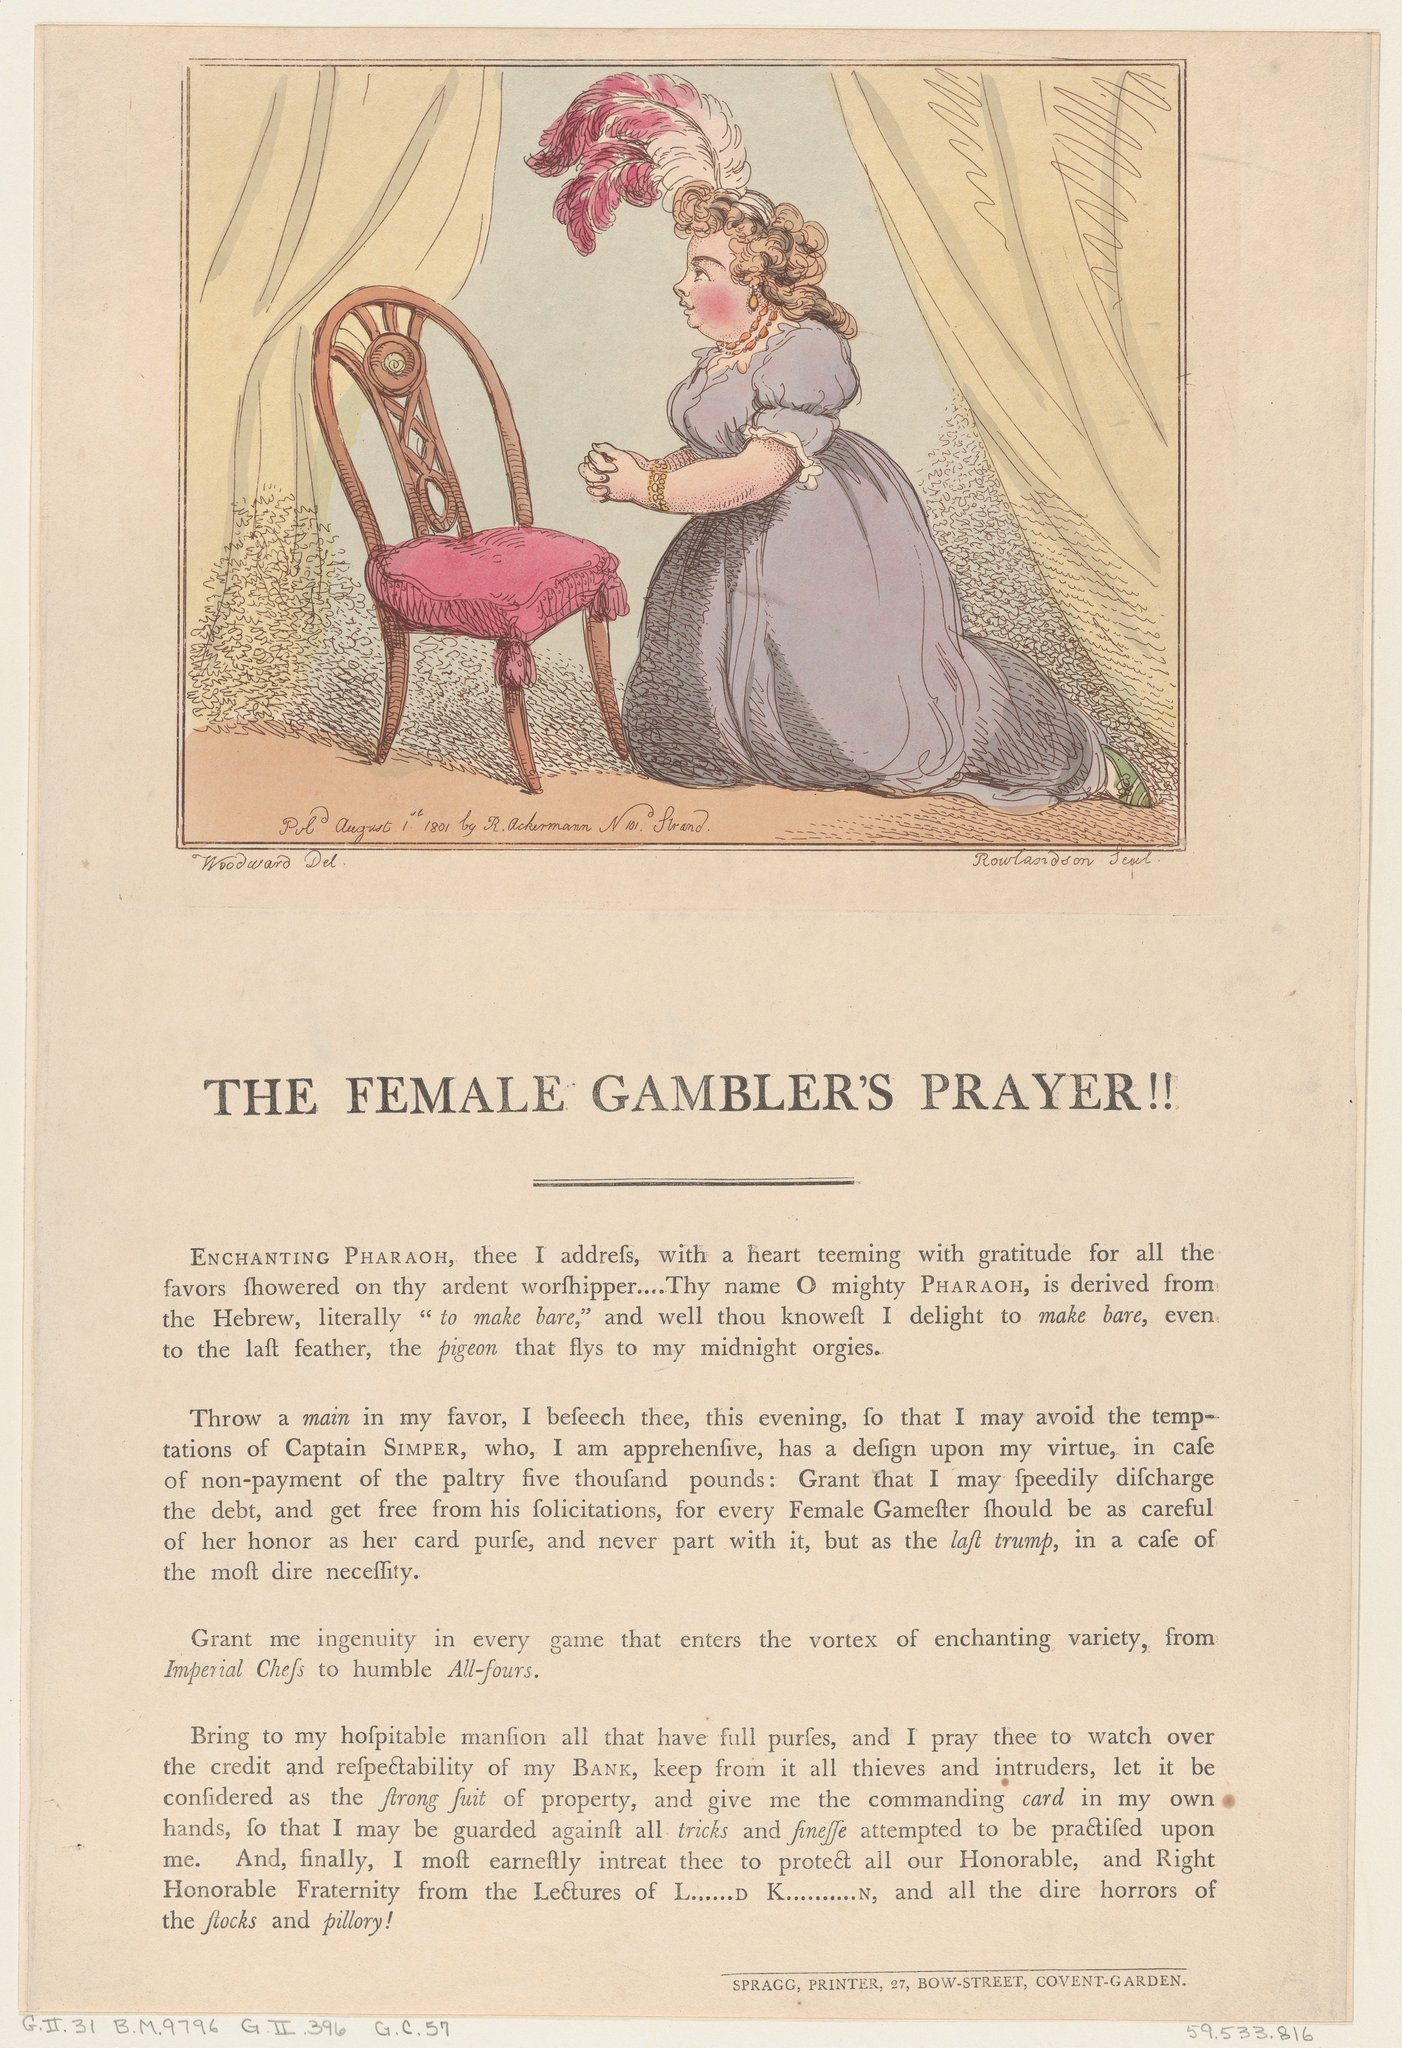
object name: print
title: The Female Gambler's Prayer!!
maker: thomas rowlandson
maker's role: artist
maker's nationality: british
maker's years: 1757-1827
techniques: etching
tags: women,chairs